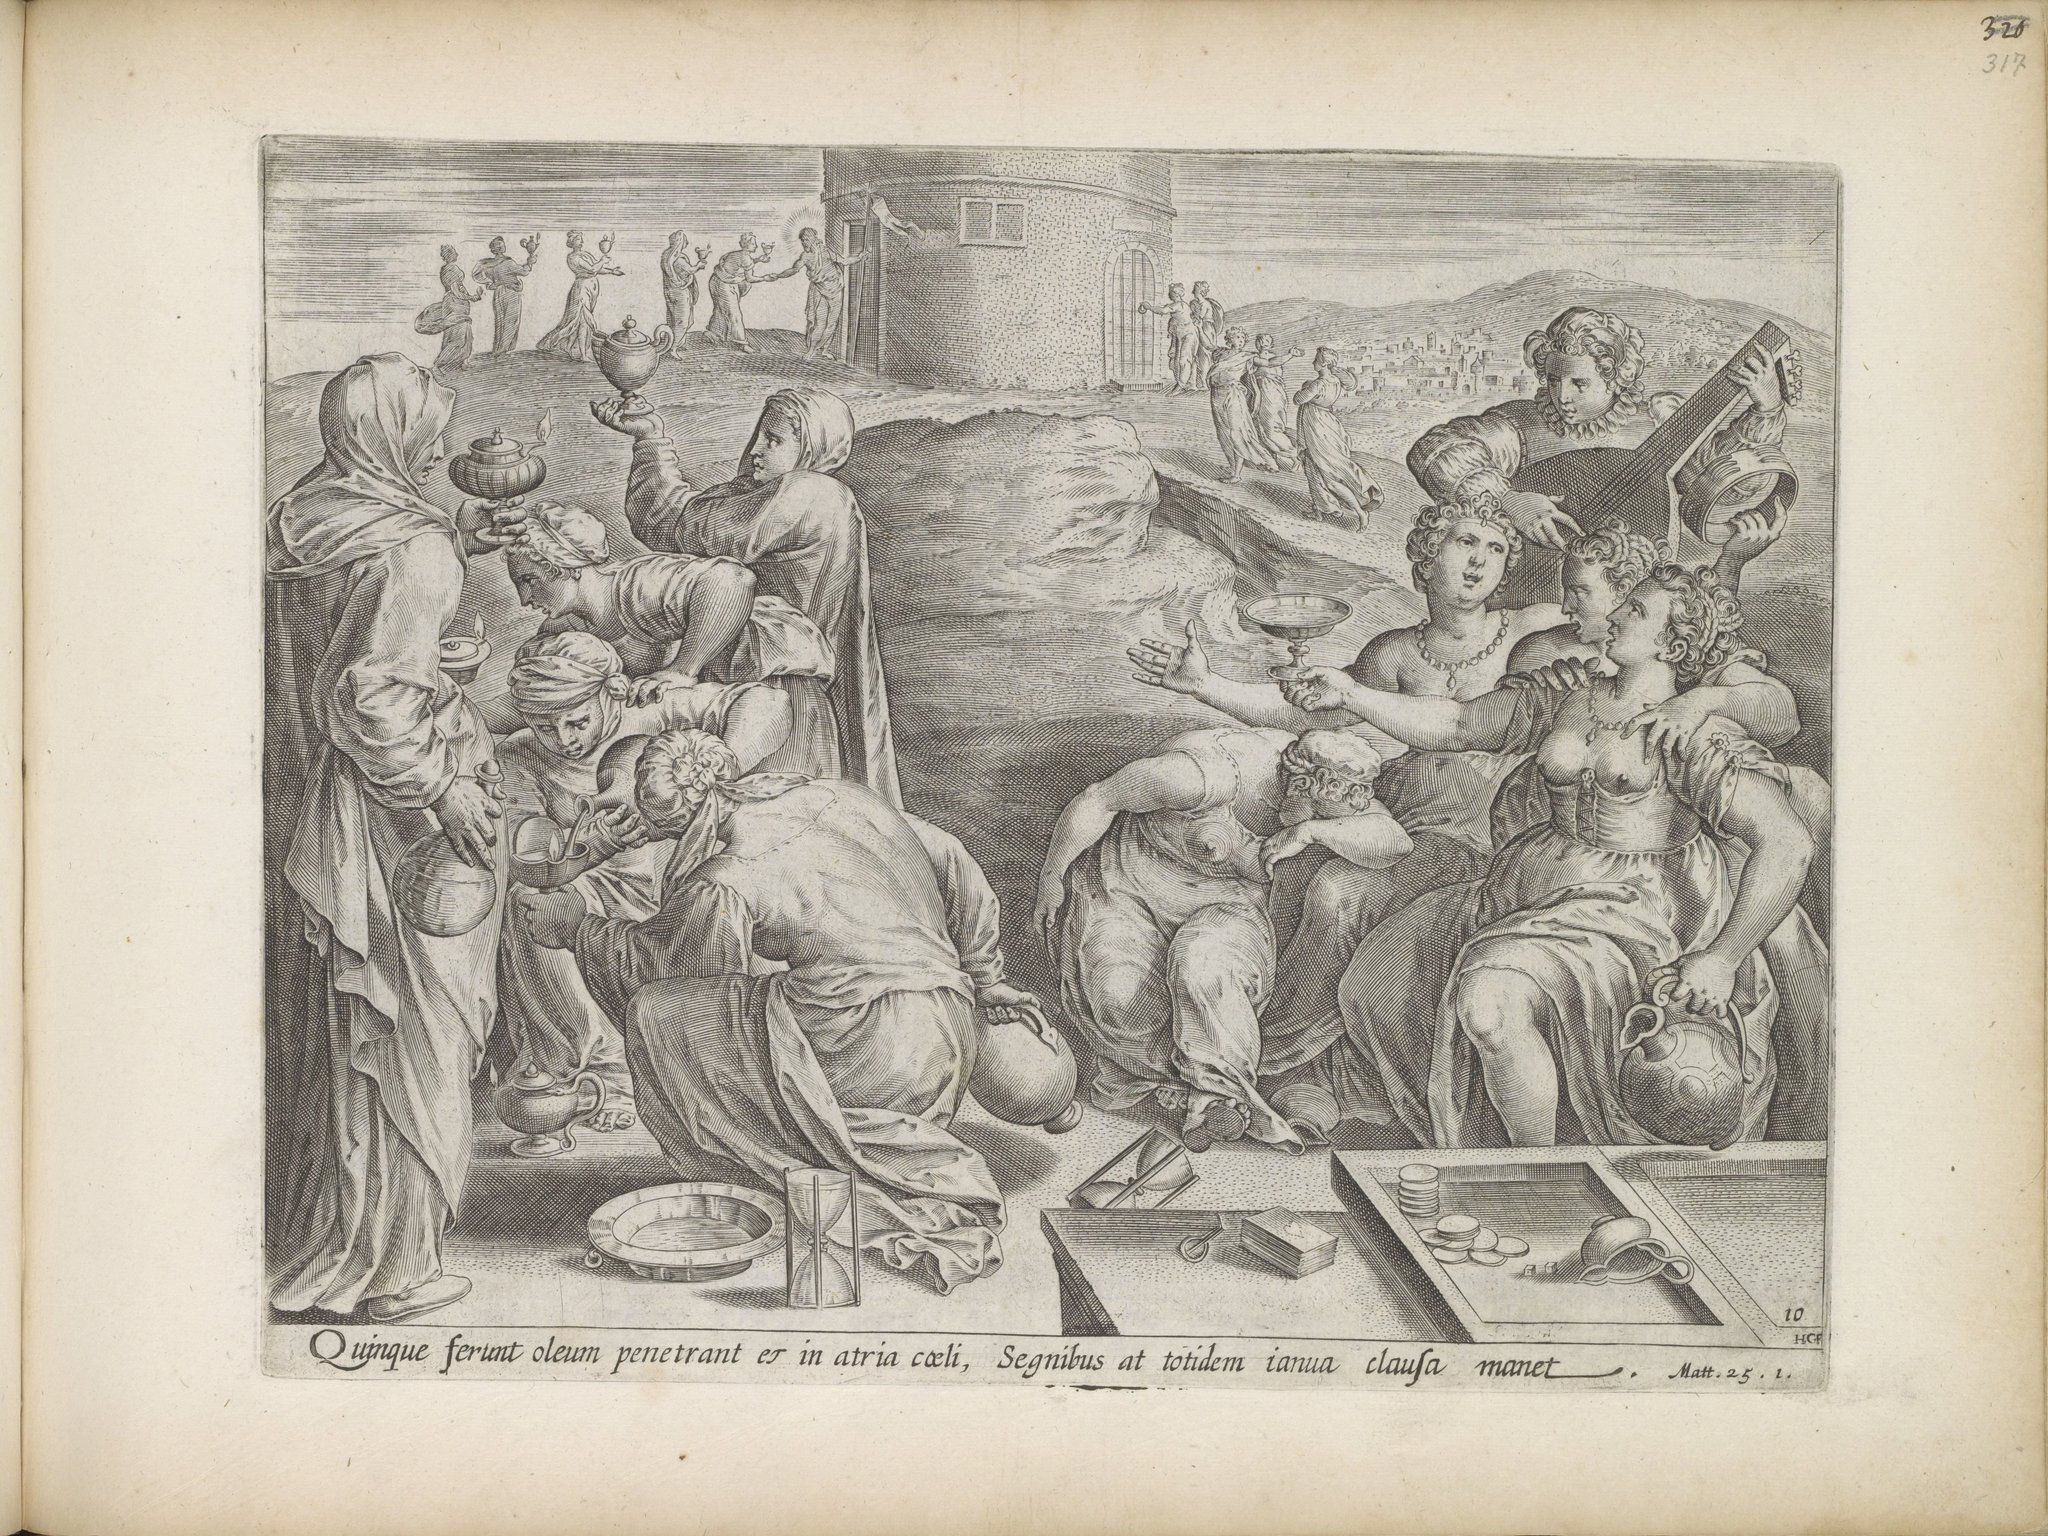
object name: print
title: Gelijkenis van de wijze en dwaze maagden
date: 1585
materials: paper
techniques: engraving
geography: amsterdam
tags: the wise virgins are let into the house with the bridegroom (christ); the foolish virgins are shut out, the wise and the foolish virgins ~ parable of christ (matthew 25:1-13)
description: De tien wijze en dwaze maagden wachten op de voorgrond op de bruidegom. De vijf wijze maagden links houden hun olielamp brandend. De vijf dwaze maagden rechts maken muziek, drinken en slapen terwijl ze hun olielamp laten liggen. Op de achtergrond ontvangt Christus als bruidegom de wijze maagden. De dwaze maagden kloppen tevergeefs op de deur. Onder de voorstelling een verwijzing in het Latijn naar de Bijbeltekst in Mat. 25:1. Deze prent maakt deel uit van een album.